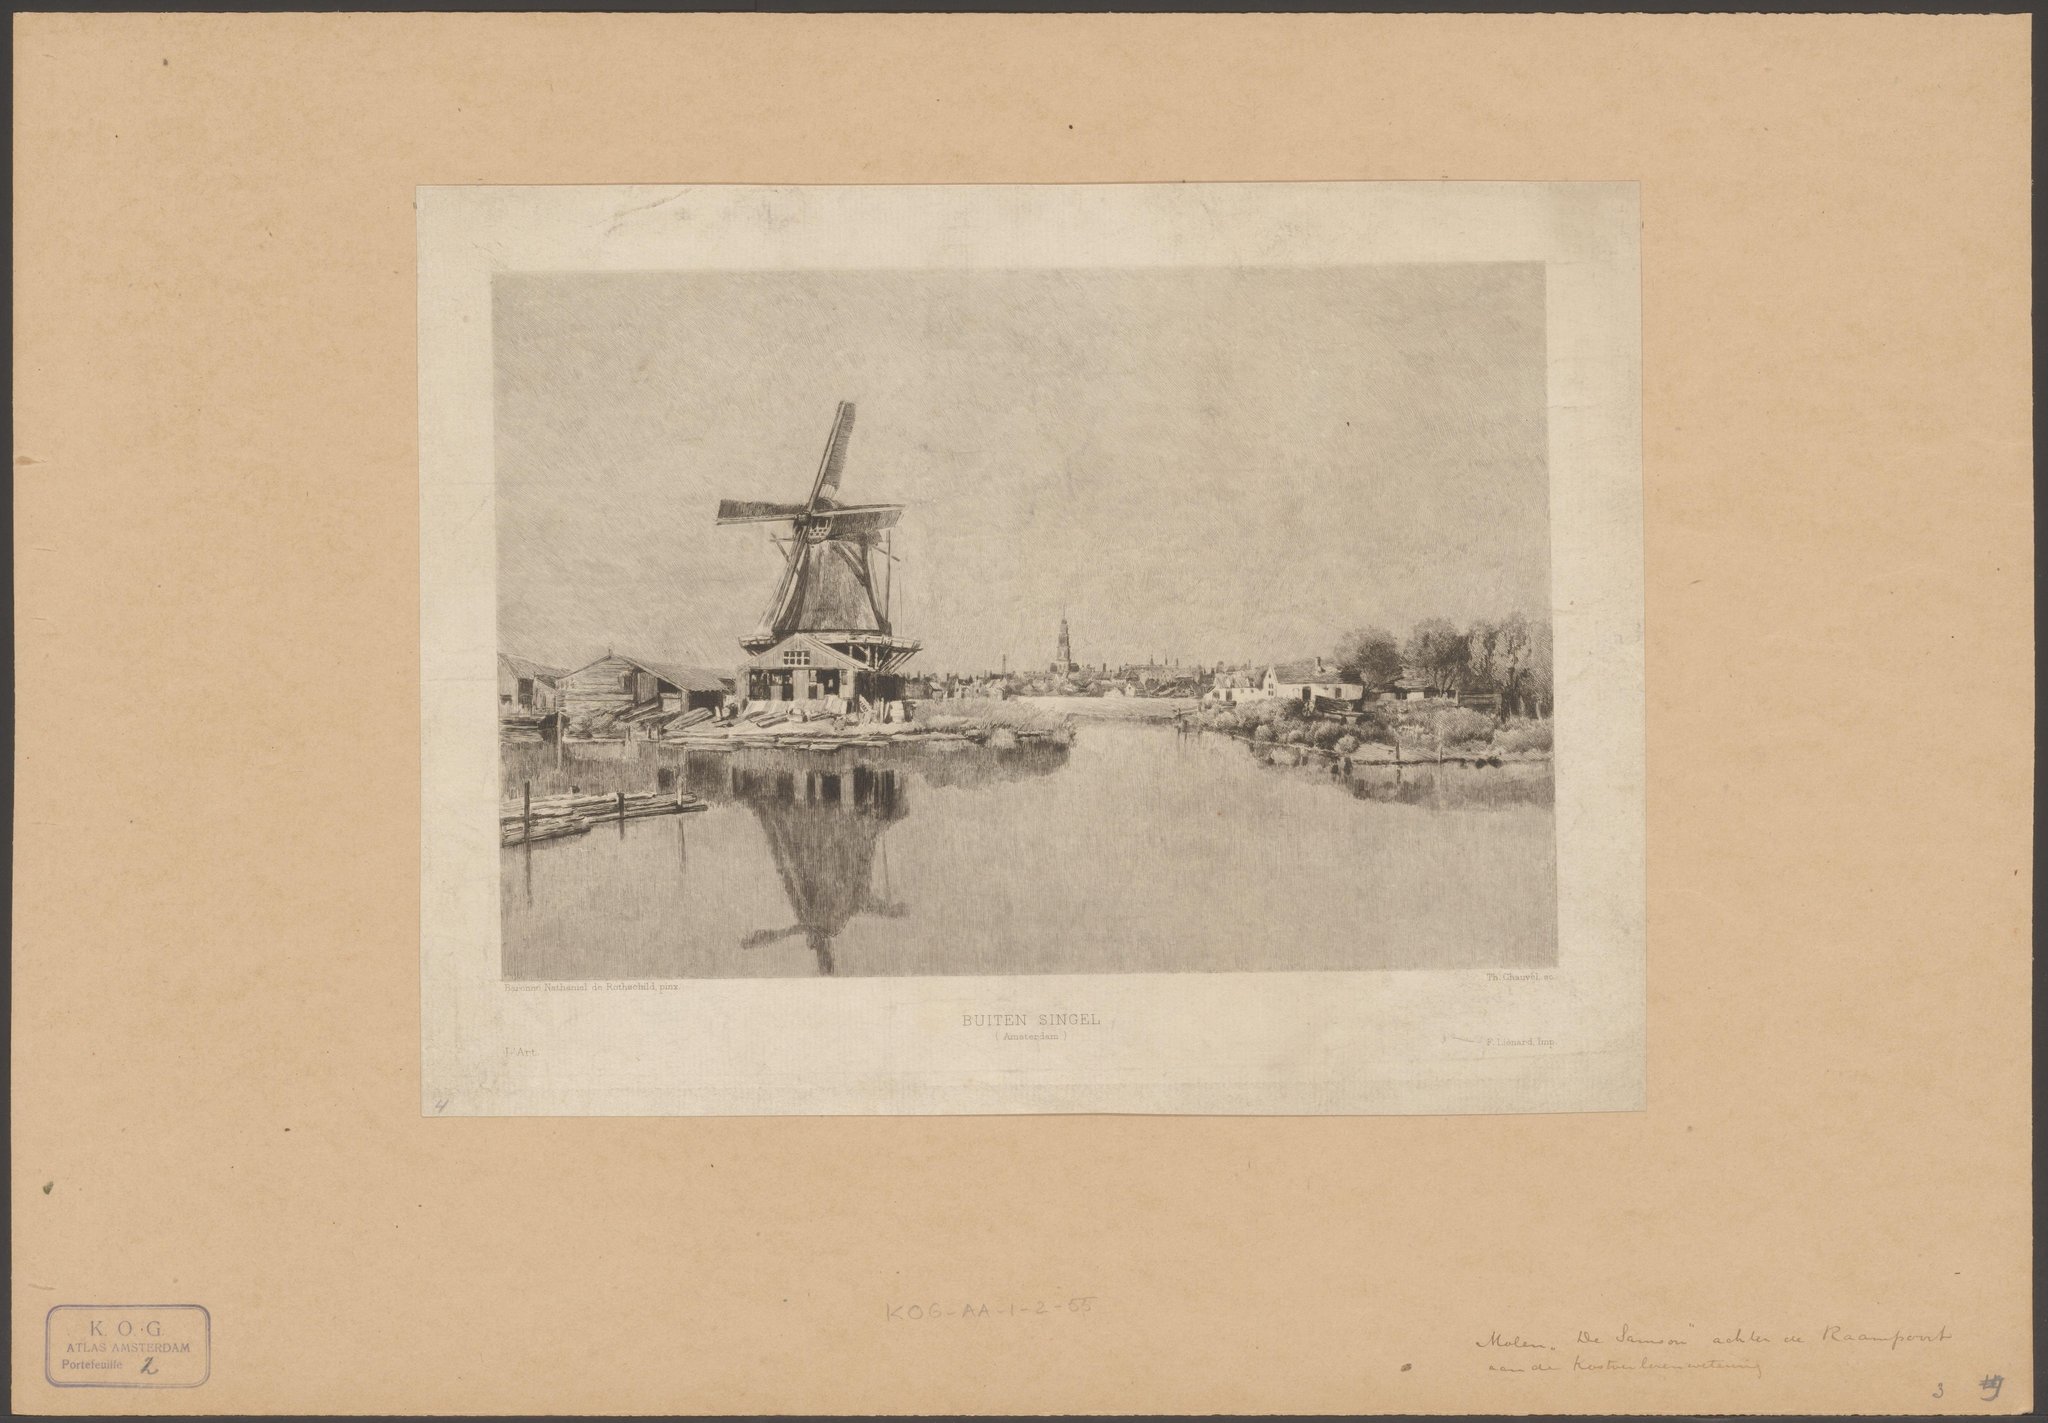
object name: print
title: Buiten Singel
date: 1860-1880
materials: paper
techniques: drypoint, etching, intaglio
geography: paris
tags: city-view in general; 'veduta', canal, windmill in landscape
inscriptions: inscription: ‘Molen "De Samson" achter de Raampoort / aan de Kostverlorenwetering’, collector's mark: ‘2’ Lugt 1641b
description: Onderwerpsrubriek binnen de Atlas Amsterdam: Kostverloren Wetering.